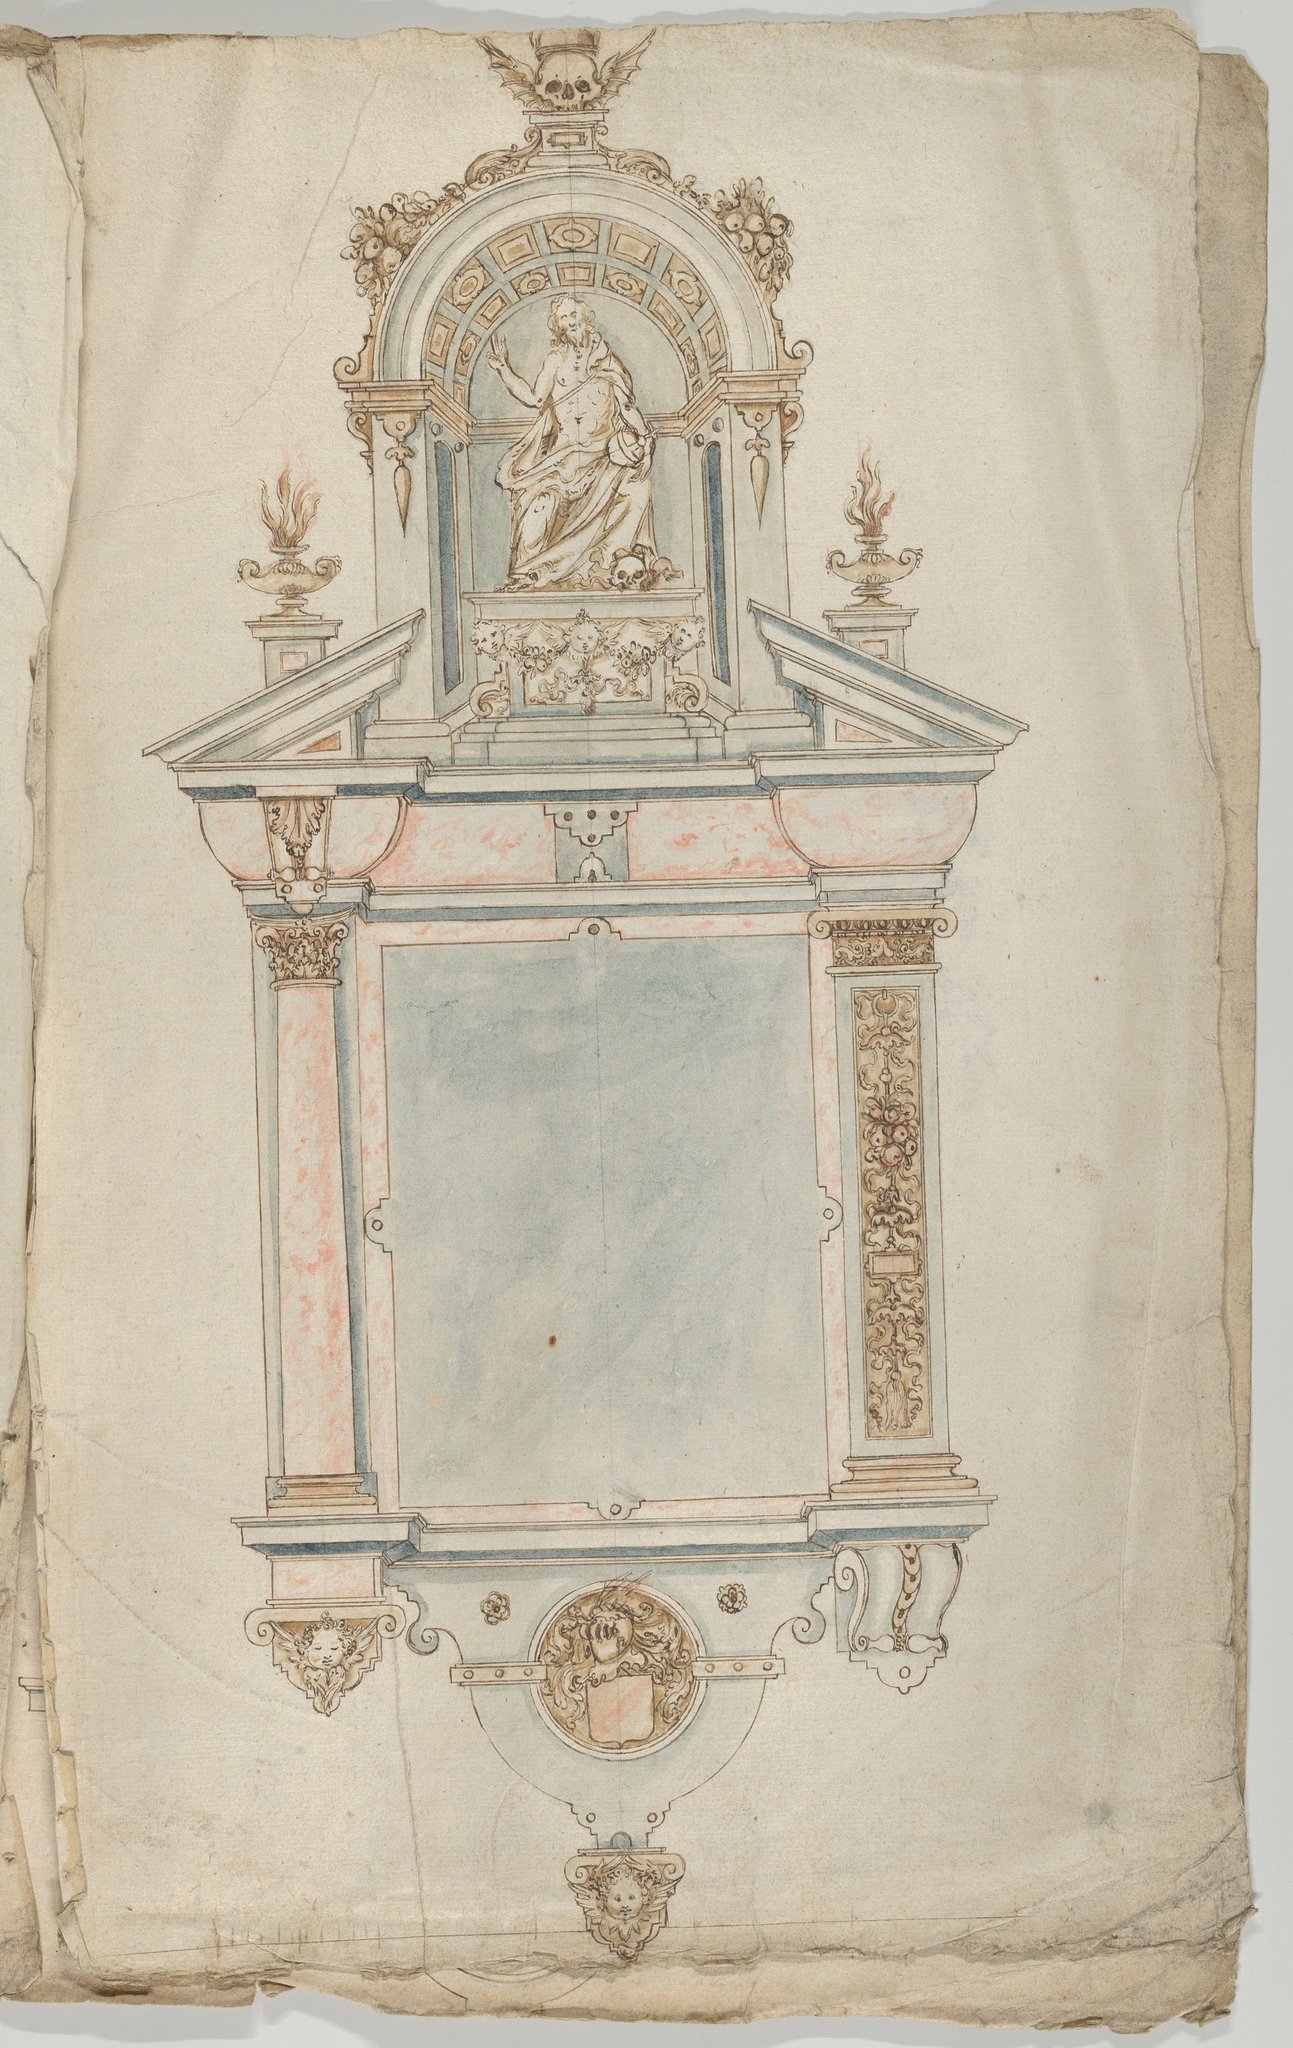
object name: drawing ornament architecture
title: Design for a Wall Tomb with a Variant and a Statue of Christ as Salvator Mundi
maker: anonymous, flemish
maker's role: artist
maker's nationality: flemish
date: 1601-1700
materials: ink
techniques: pen, wash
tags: architecture,tombs,christ